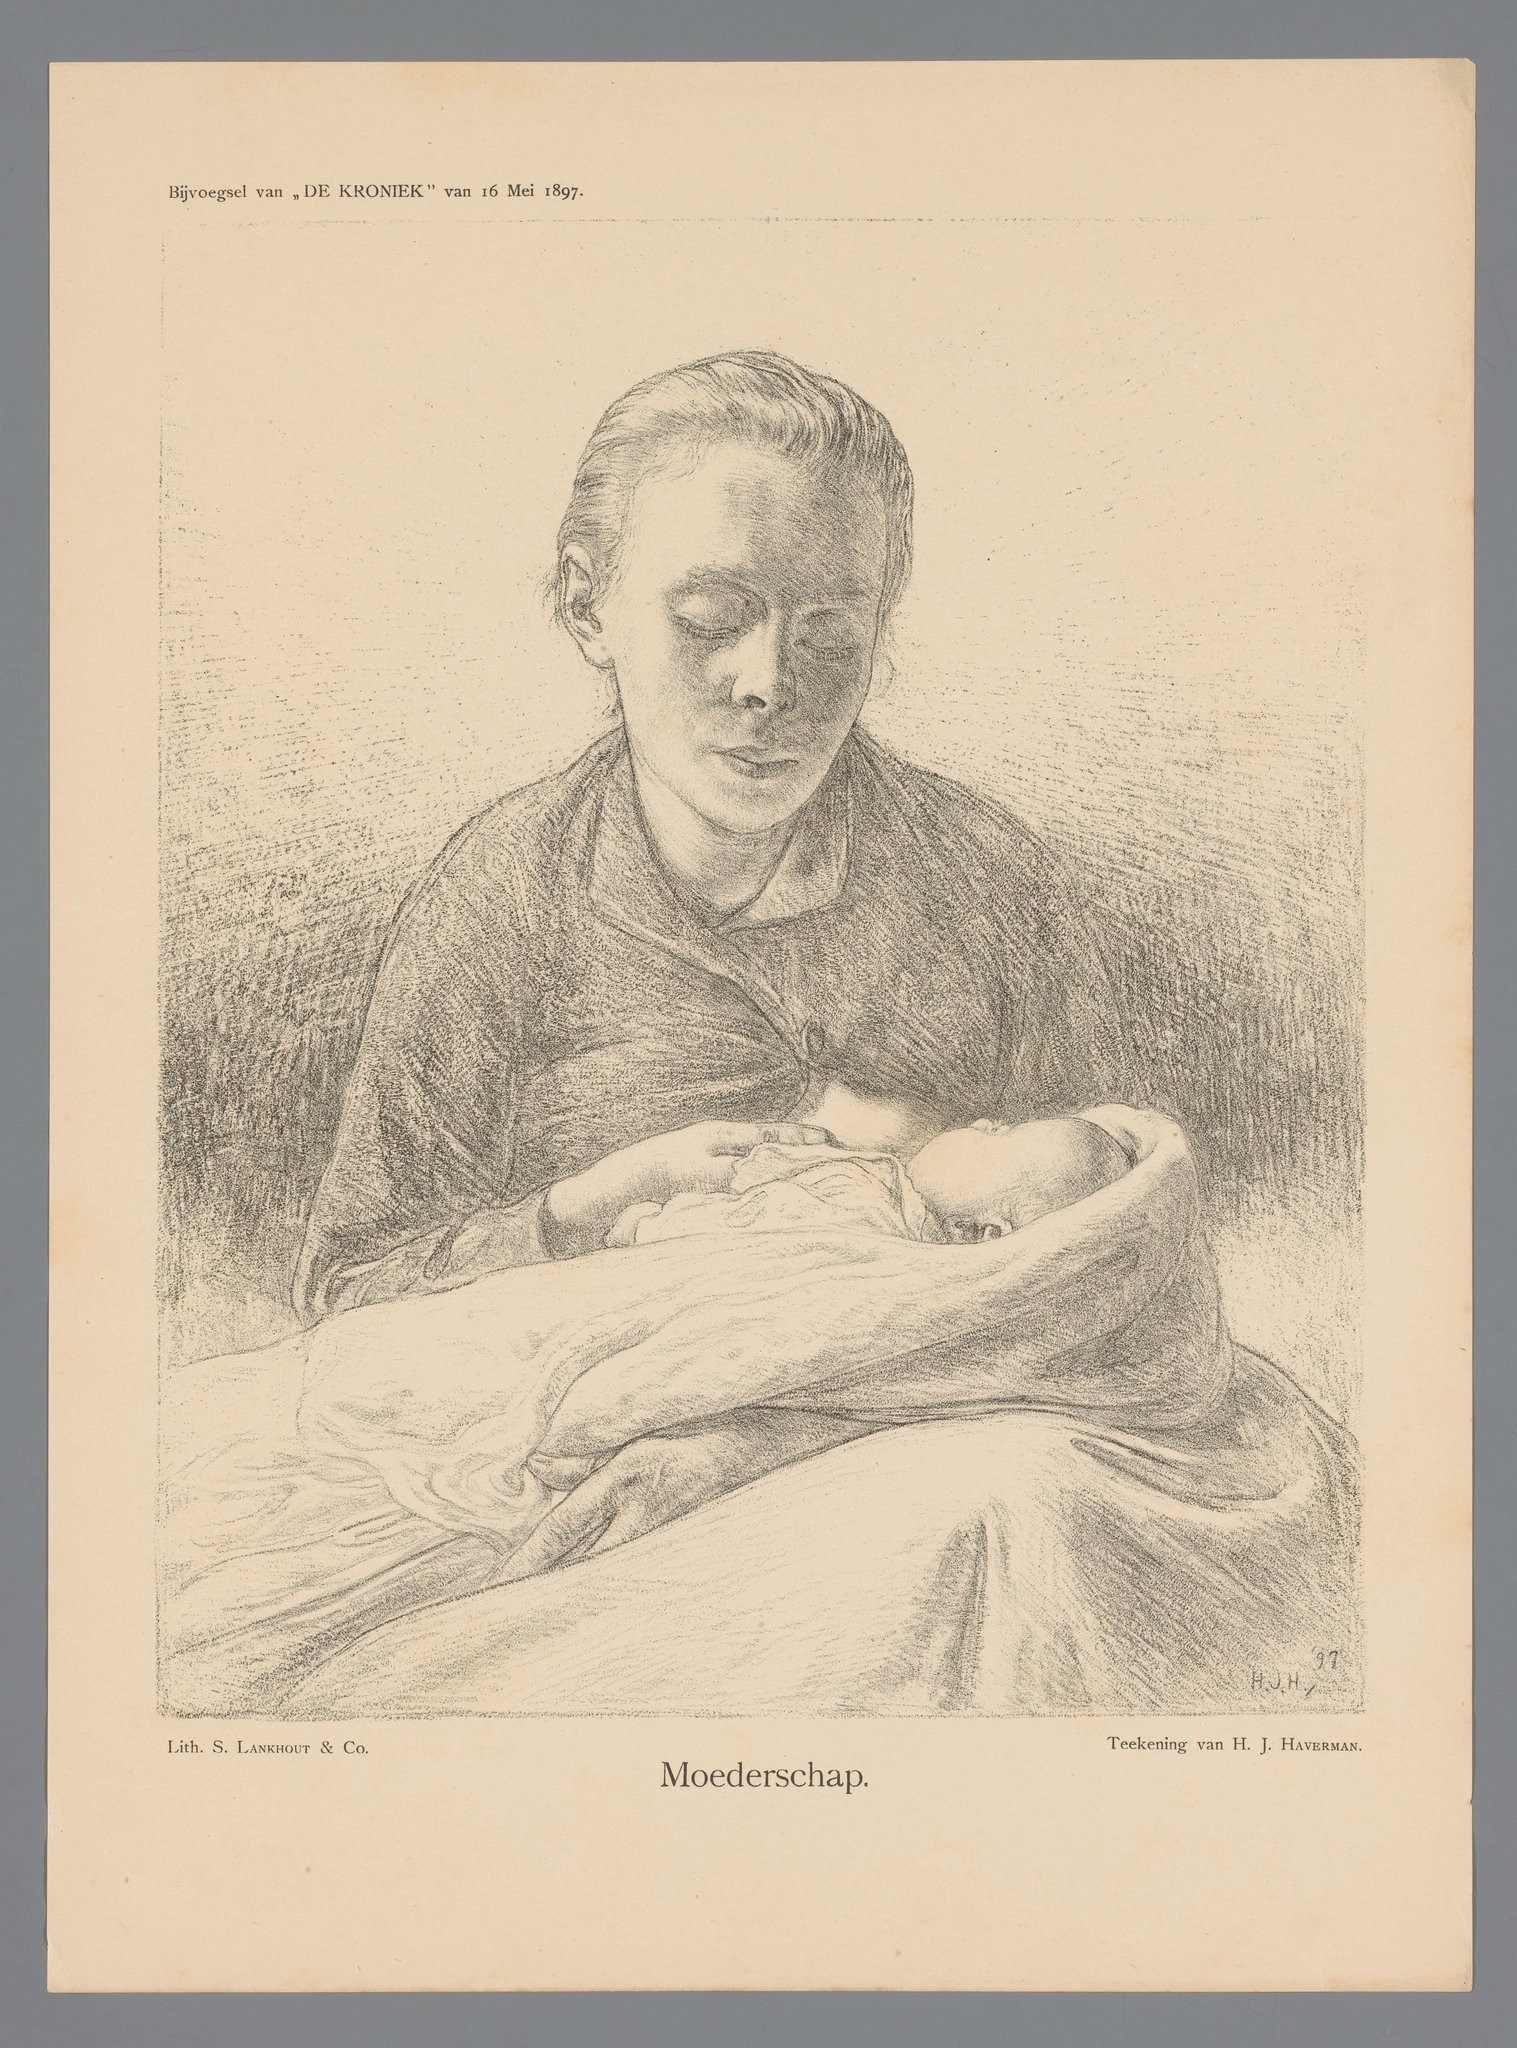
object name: print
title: Moederschap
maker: hendrik johannes haverman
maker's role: draughtsman, print maker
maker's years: 1857-1928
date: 1897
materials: paper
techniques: lithograph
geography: the hague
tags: mother and baby or young child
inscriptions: date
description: Prent uit het bijvoegsel van: De Kroniek 3 (1897), 16 mei 1897.